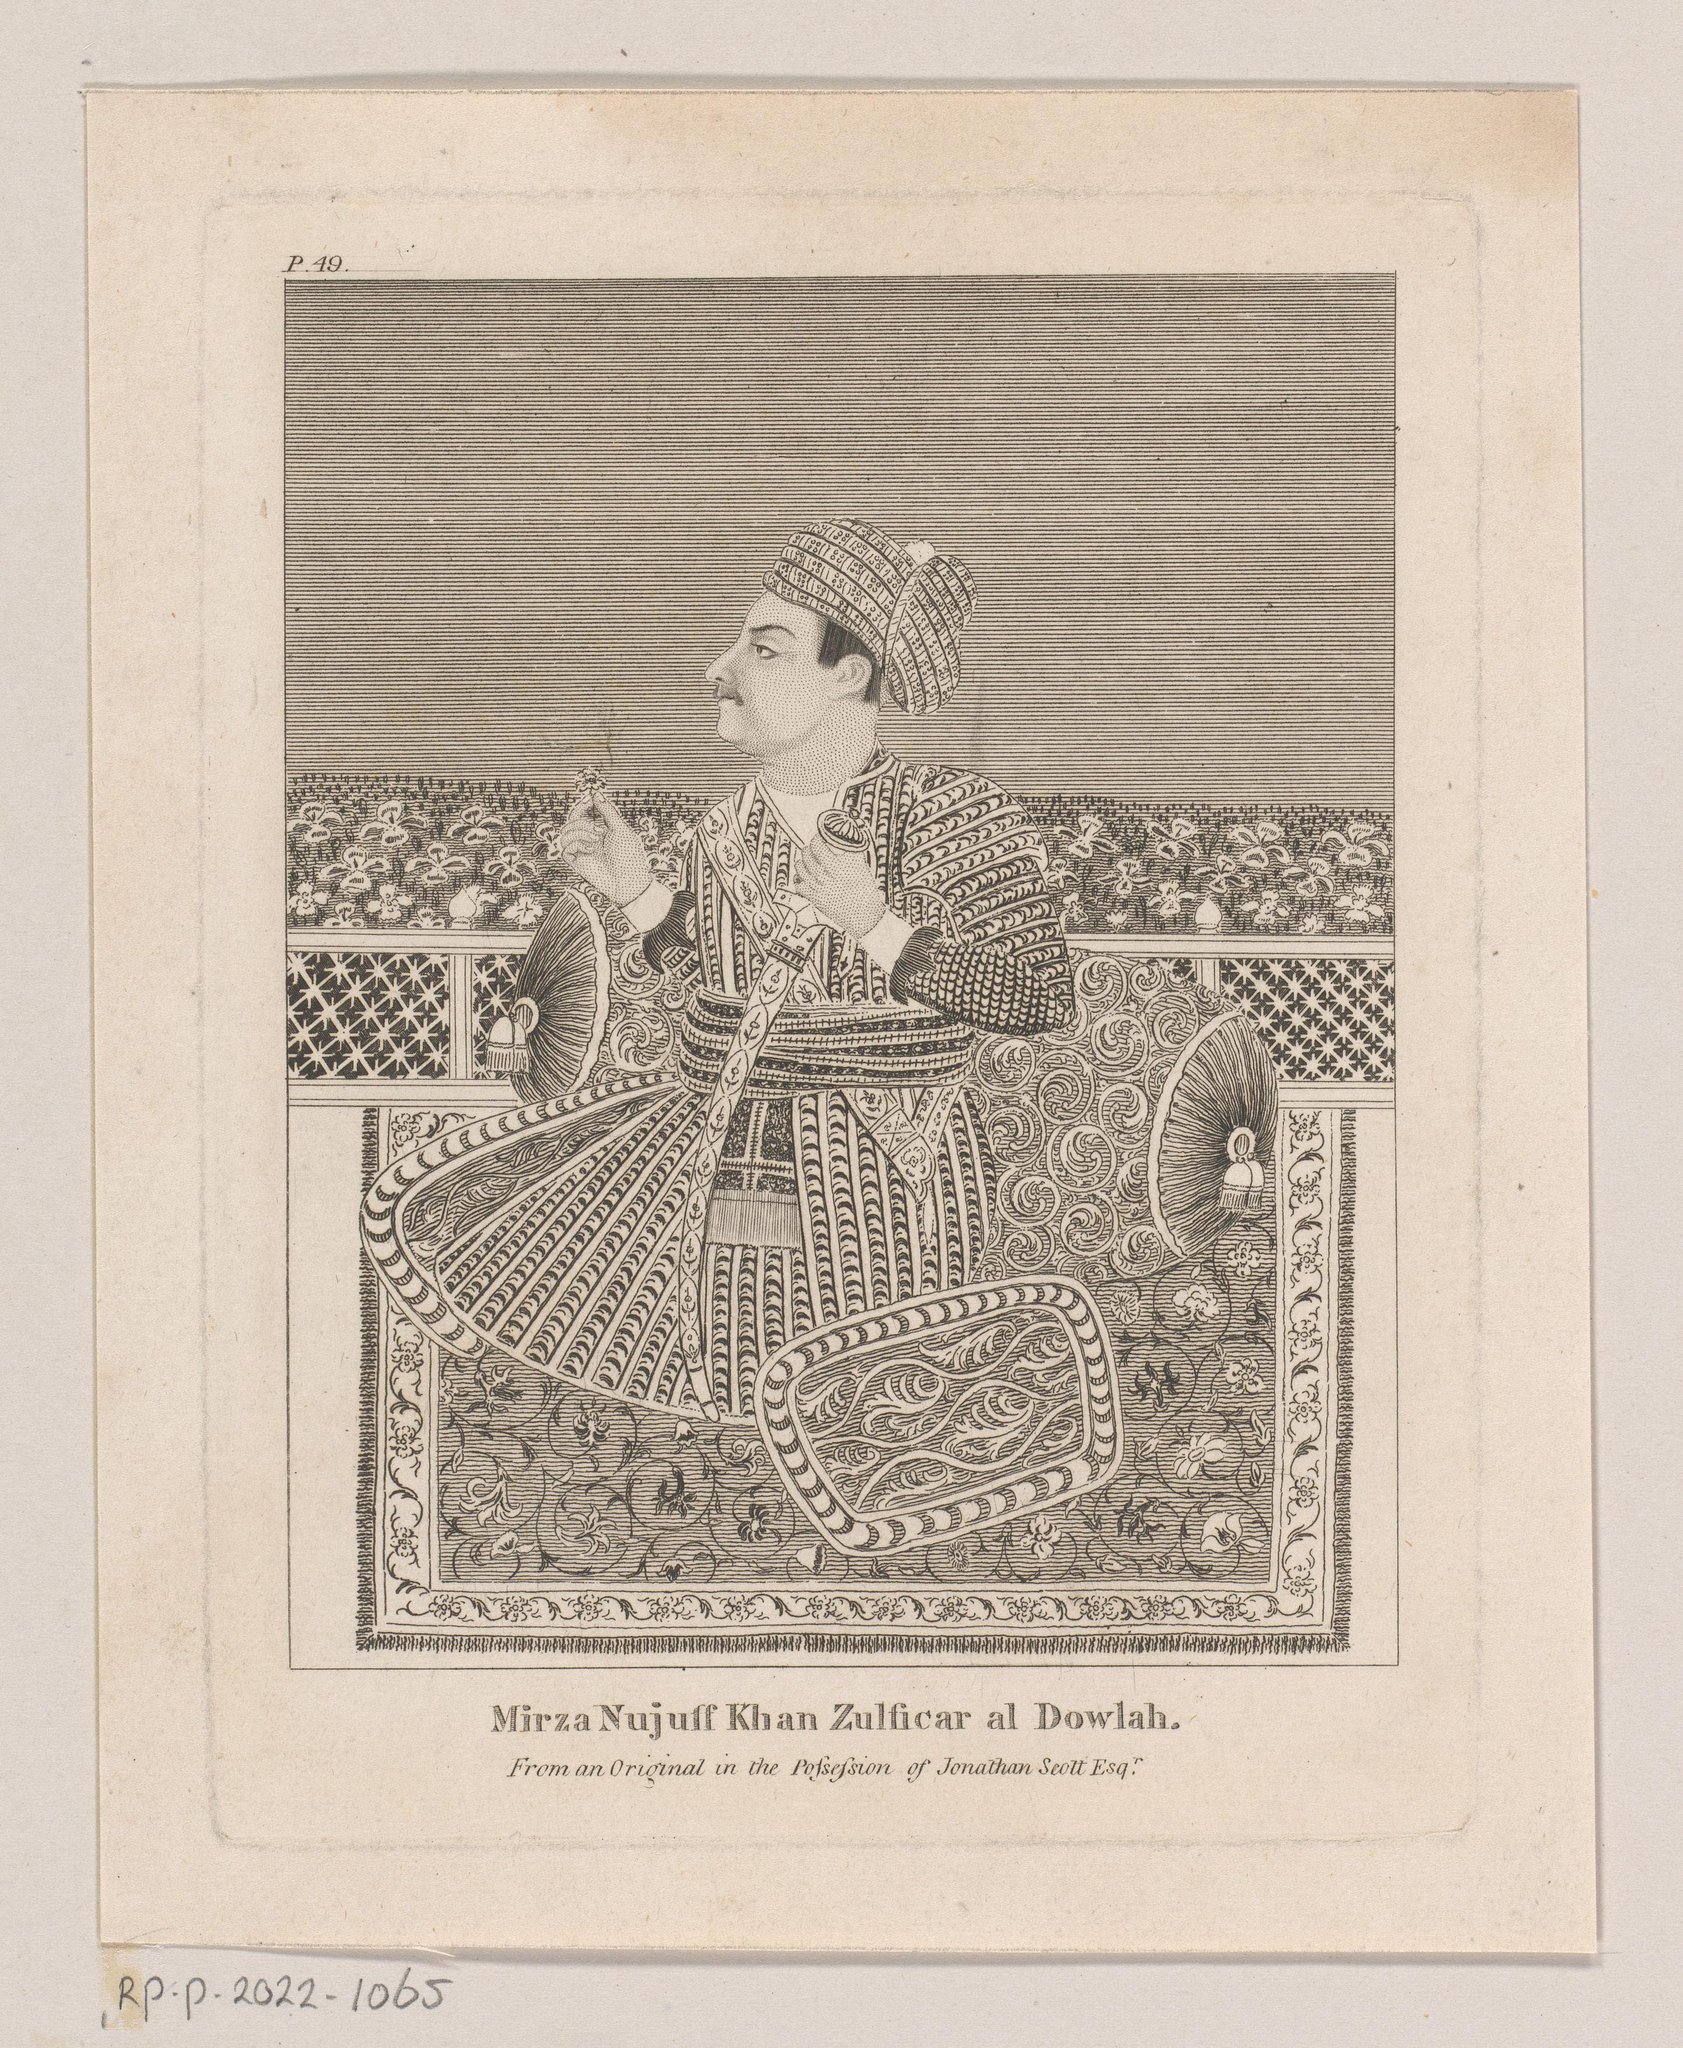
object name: print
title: Portret van Mirza Najaf Khan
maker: Anonymous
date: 1750-1850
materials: paper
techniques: etching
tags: historical persons, the soldier; the soldier's life